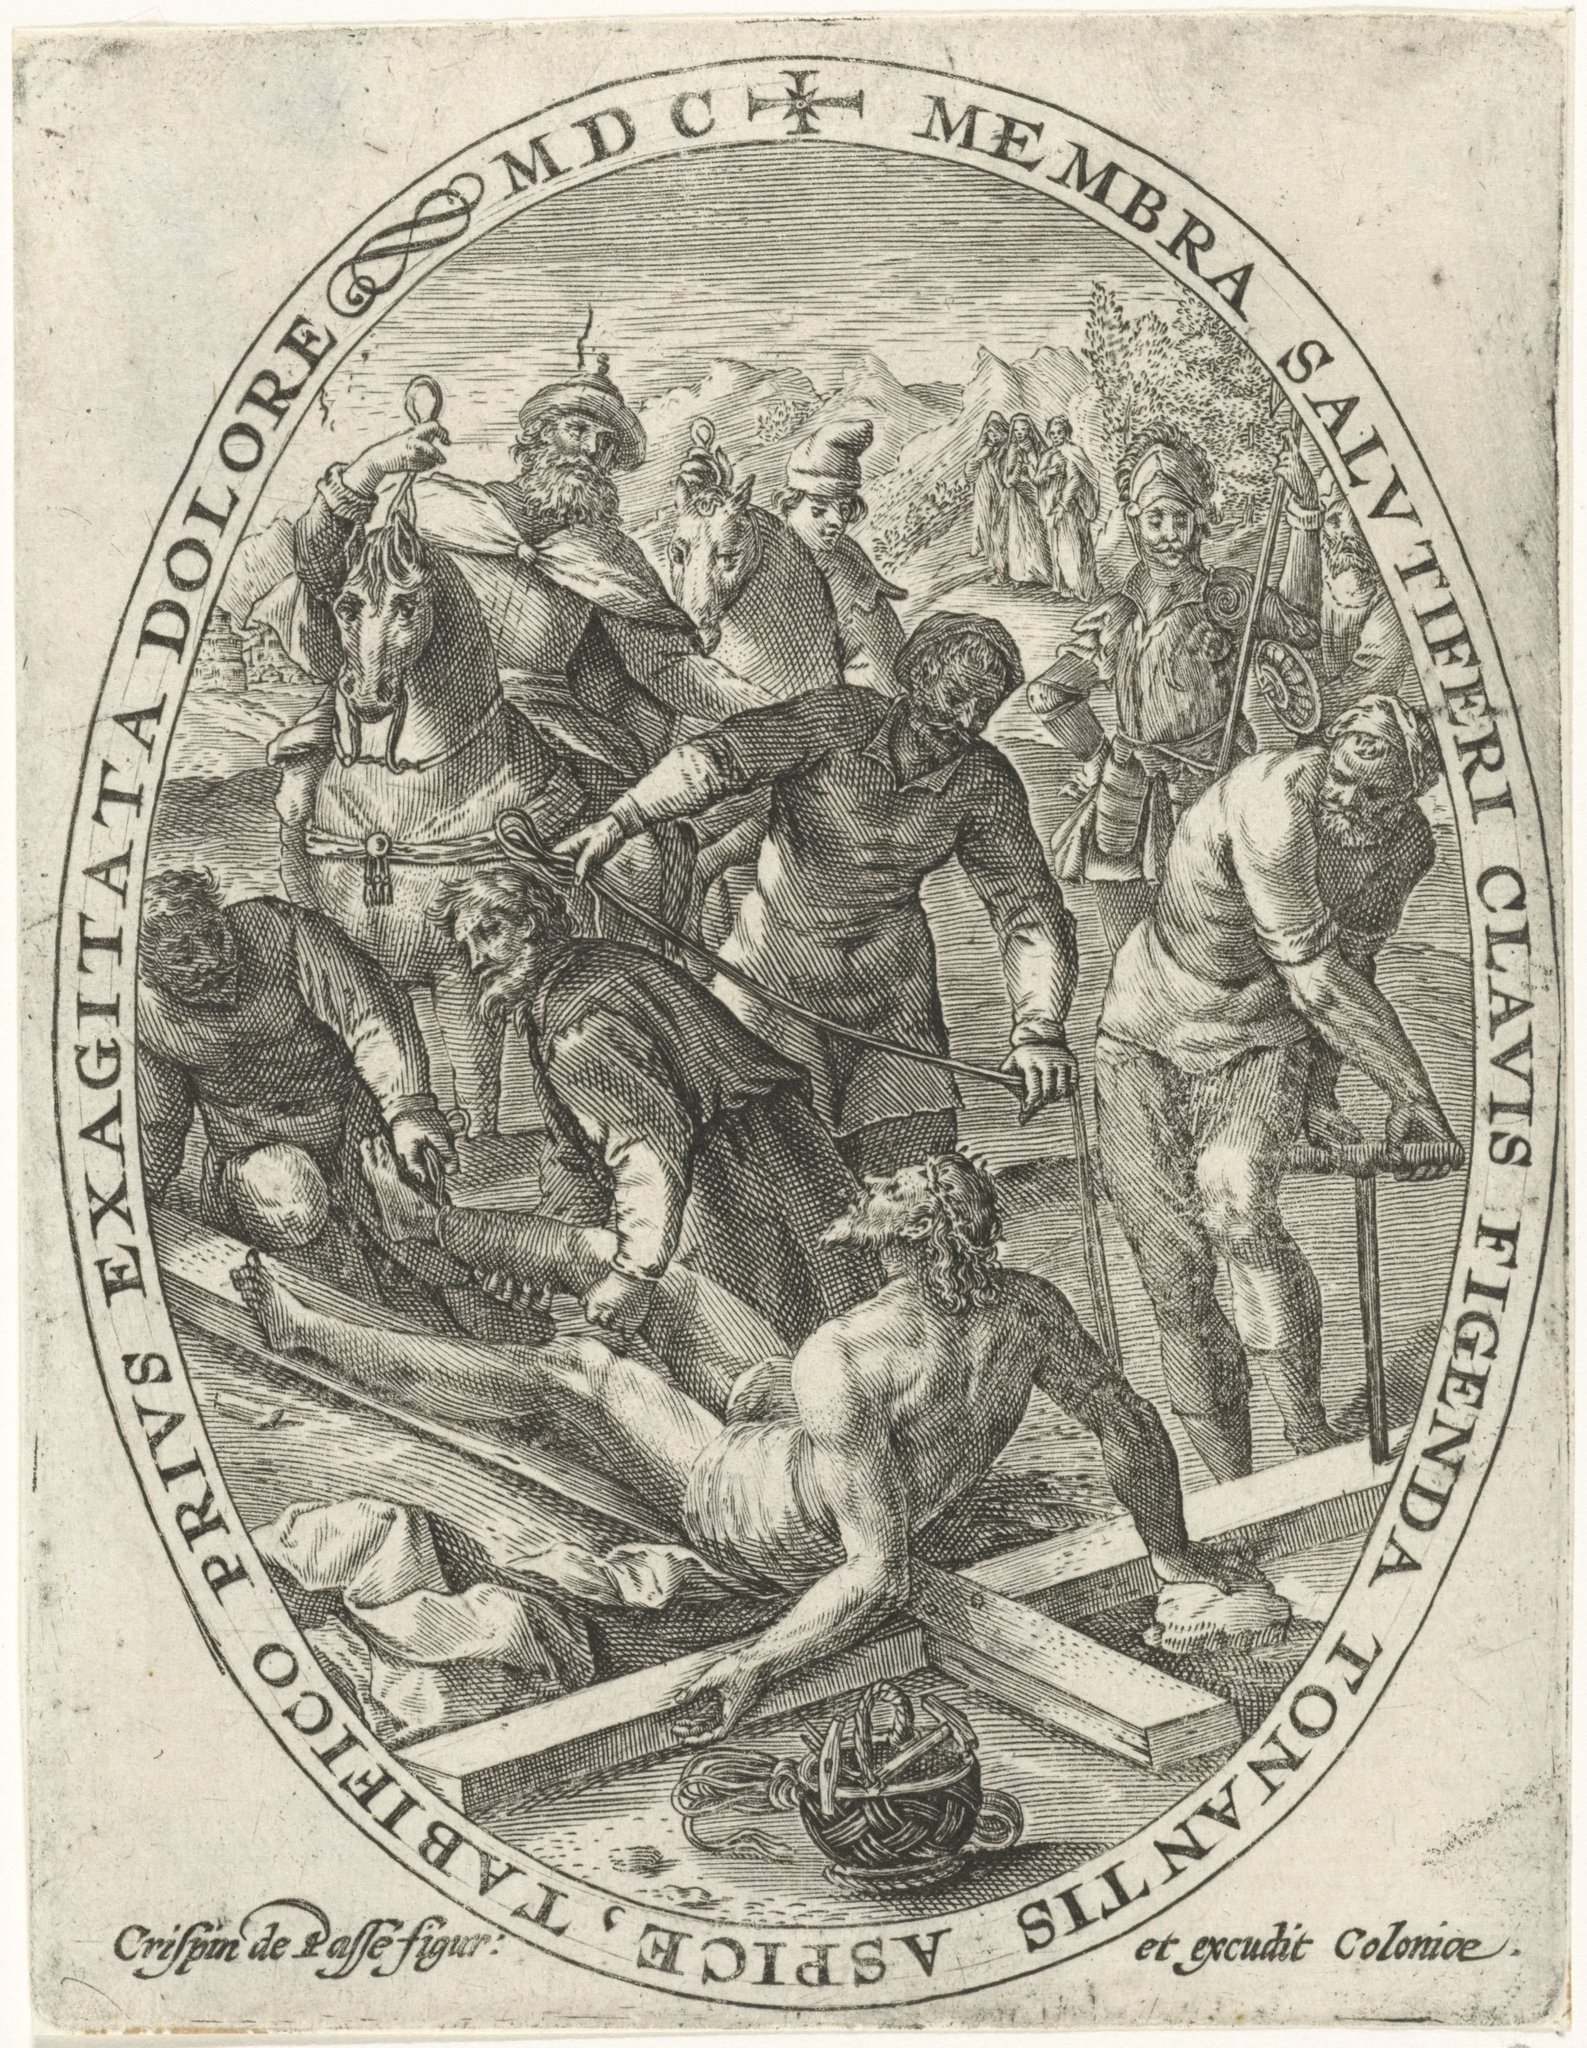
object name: print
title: Christus wordt aan het kruis genageld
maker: crispijn van de passe (i)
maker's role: draughtsman, print maker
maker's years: 1564-1637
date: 1600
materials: paper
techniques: engraving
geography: cologne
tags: the erection of the cross: christ is nailed to the cross which lies on the ground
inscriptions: collector's mark: Lugt 2542, collector's mark: Lugt 2228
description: Christus wordt aan het kruis genageld. Op de voorgrond een mand met touw, spijkers en een hamer. Op de achtergrond Maria, Maria Magdalena en Johannes de Doper. De voorstelling is gevat in een ovale omlijsting met een randschrift in het Latijn. Prent uit een serie met de passie van Christus.